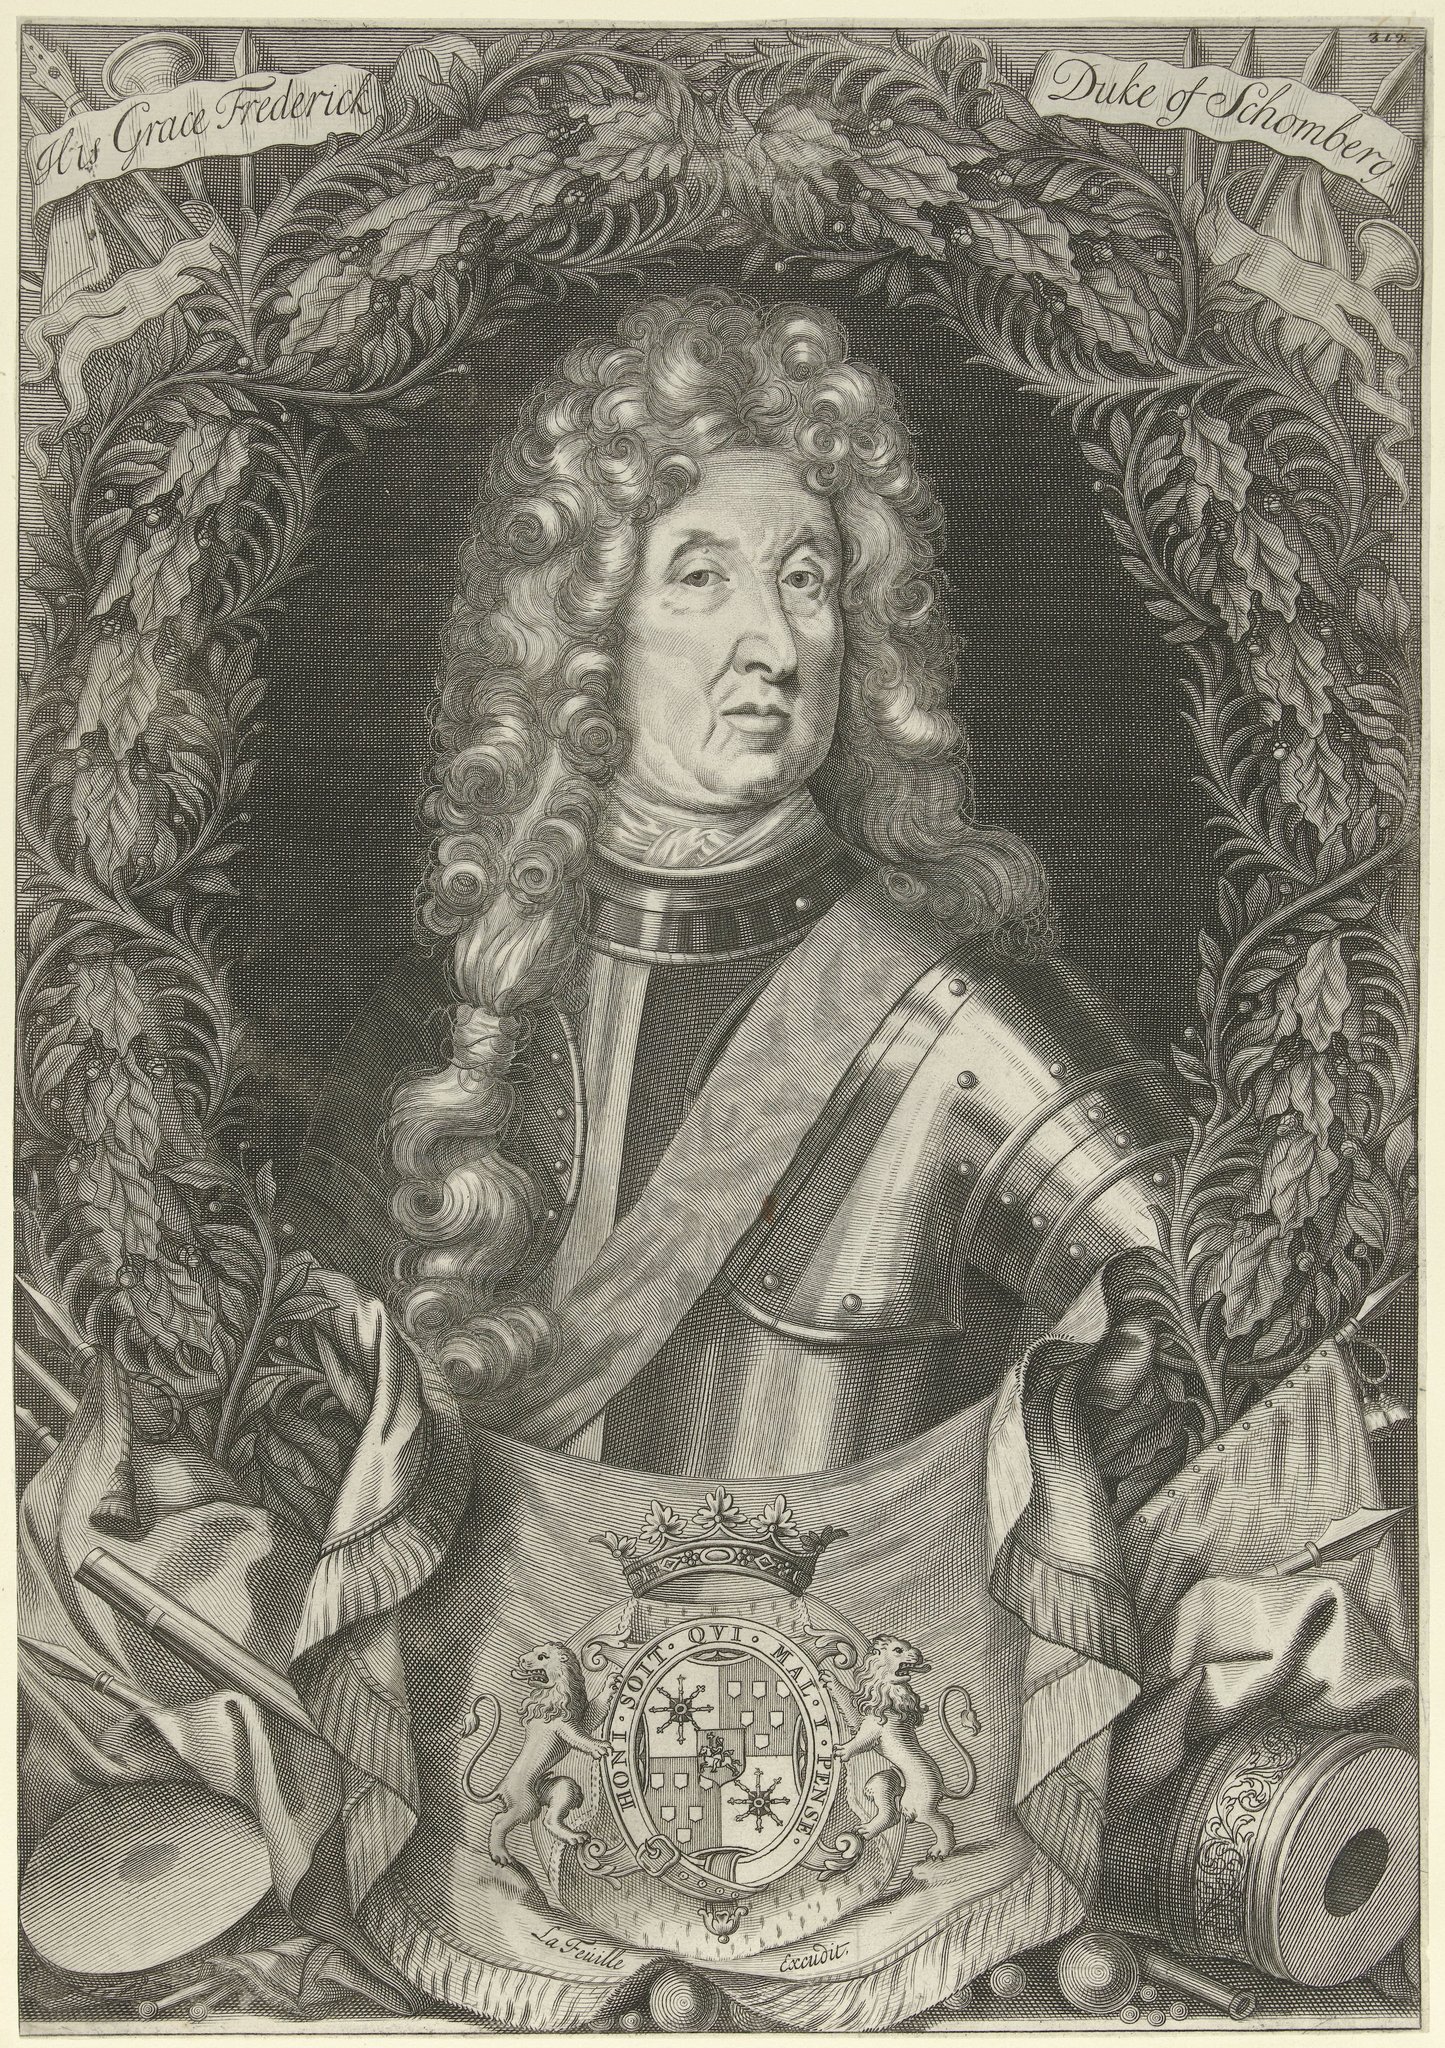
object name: print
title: Portret van Friedrich Arnaud, hertog van Schomberg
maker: daniel de lafeuille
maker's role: print maker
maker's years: 1640-1709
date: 1650-1709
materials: paper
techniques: engraving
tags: heidelberg, boyne battlesite, veldheer, frederik van schomberg (hertog)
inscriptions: collector's mark: Lugt 2228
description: Portret van de veldheer Friedrich Arnaud, hertog van Schomberg. Onderaan een wapen met het insigne van de Orde van de Kousenband: Honi soit qui mal y pense.